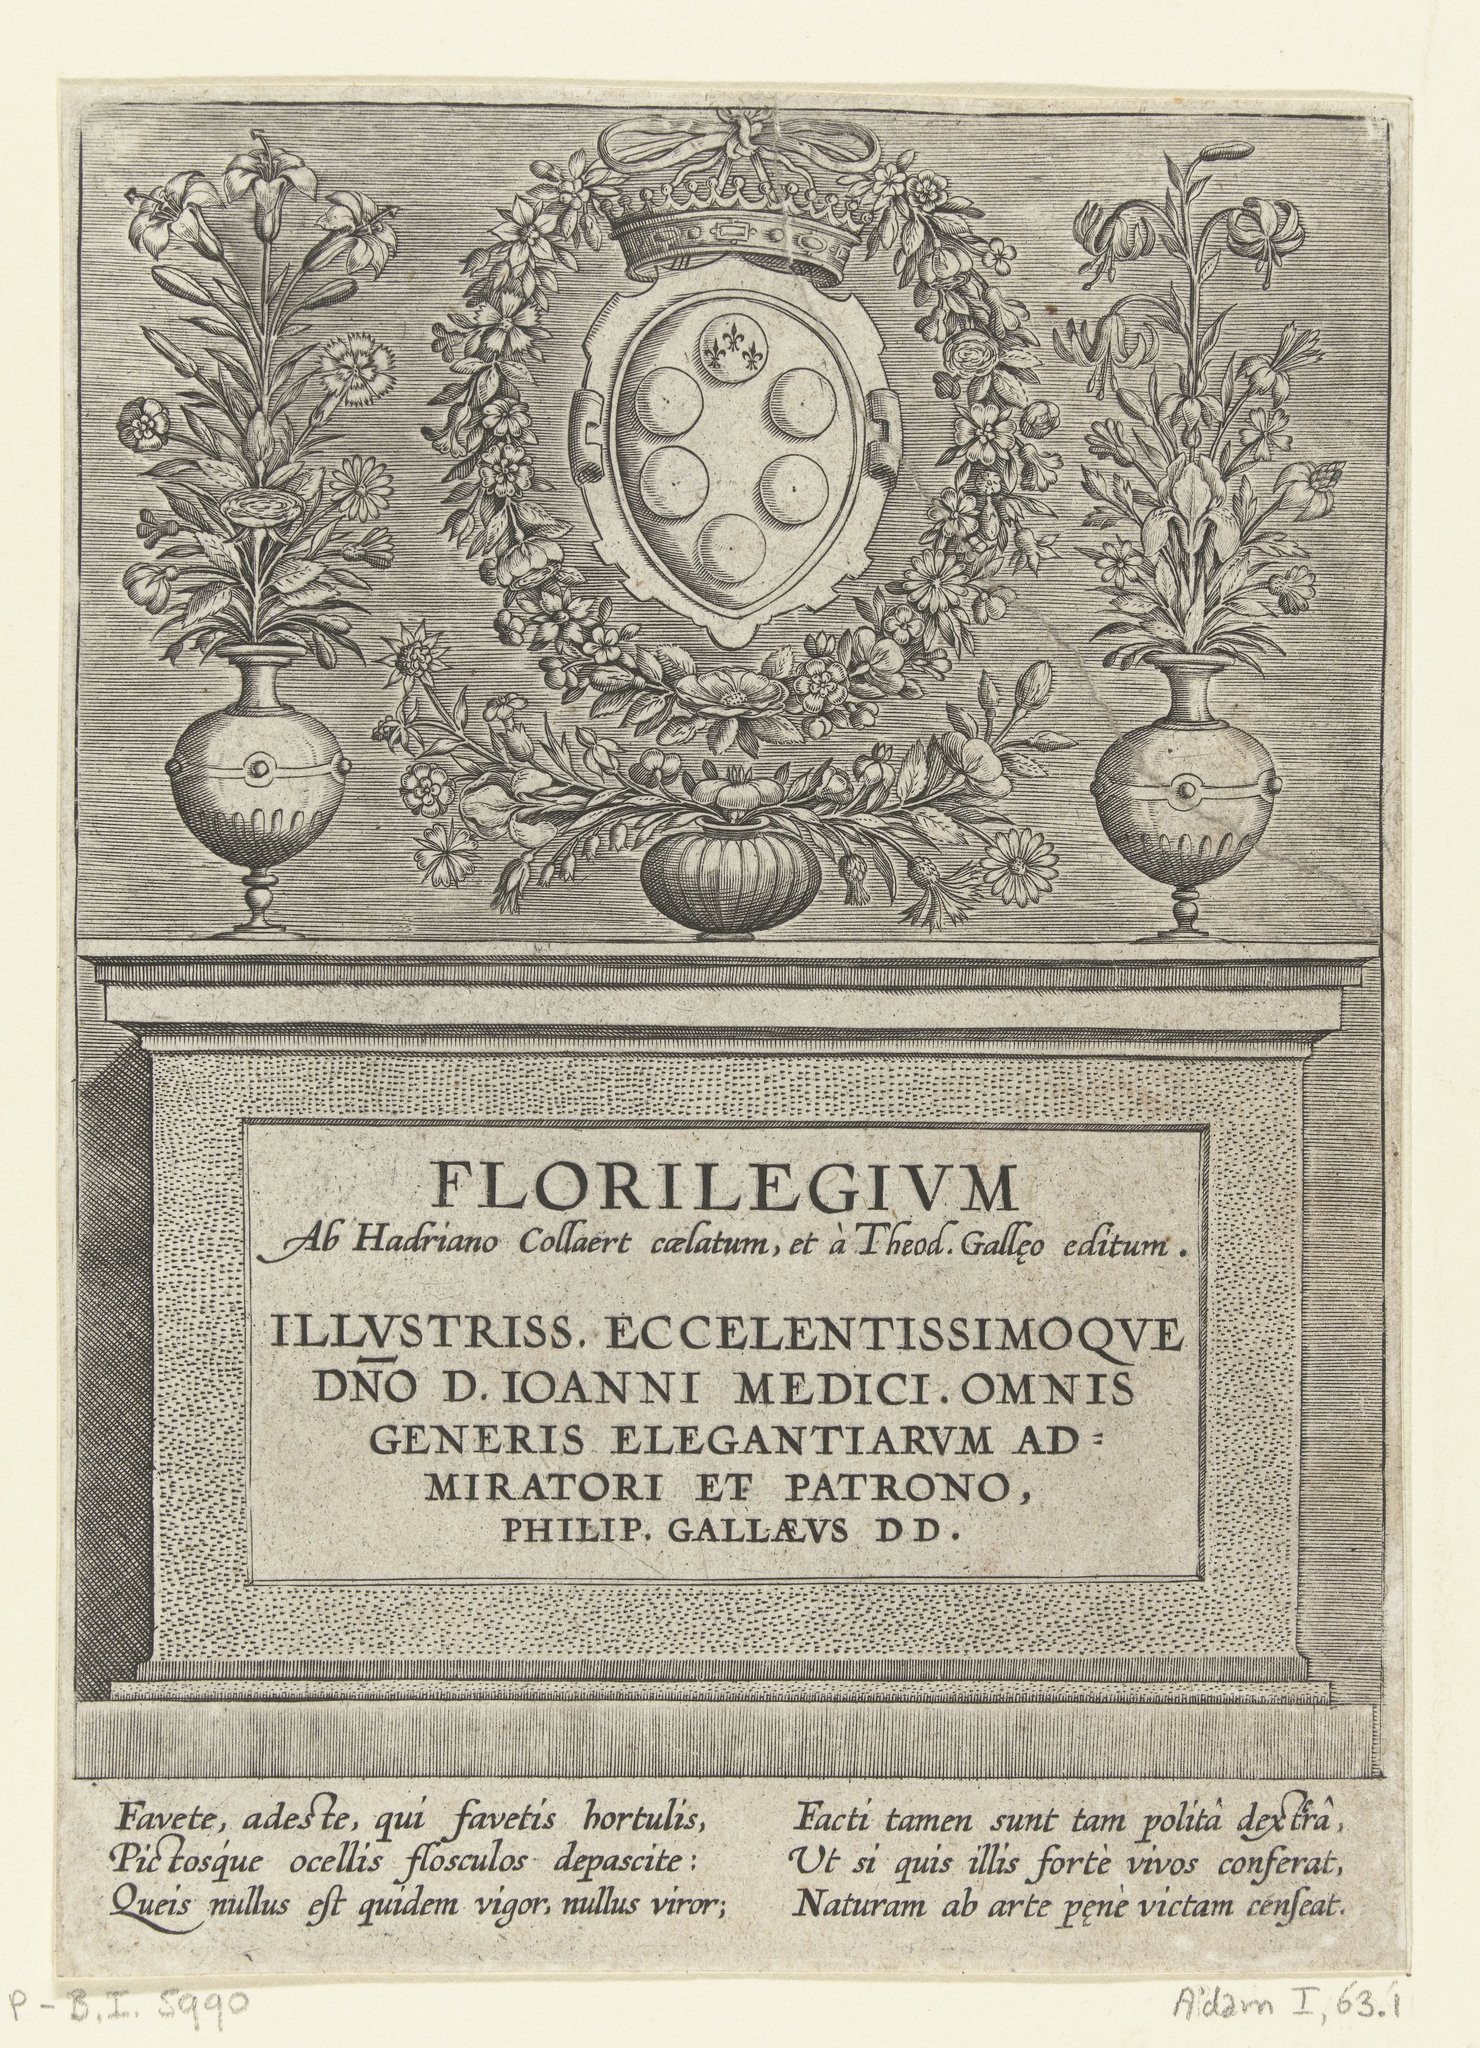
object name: titelblad, titelpagina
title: Florilegium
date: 1570-1618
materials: paper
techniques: engraving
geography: netherlands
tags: vase ~ ornament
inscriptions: collector's mark: Lugt 240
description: Titelblad van 21 genummerde bladen uit een serie van 24.